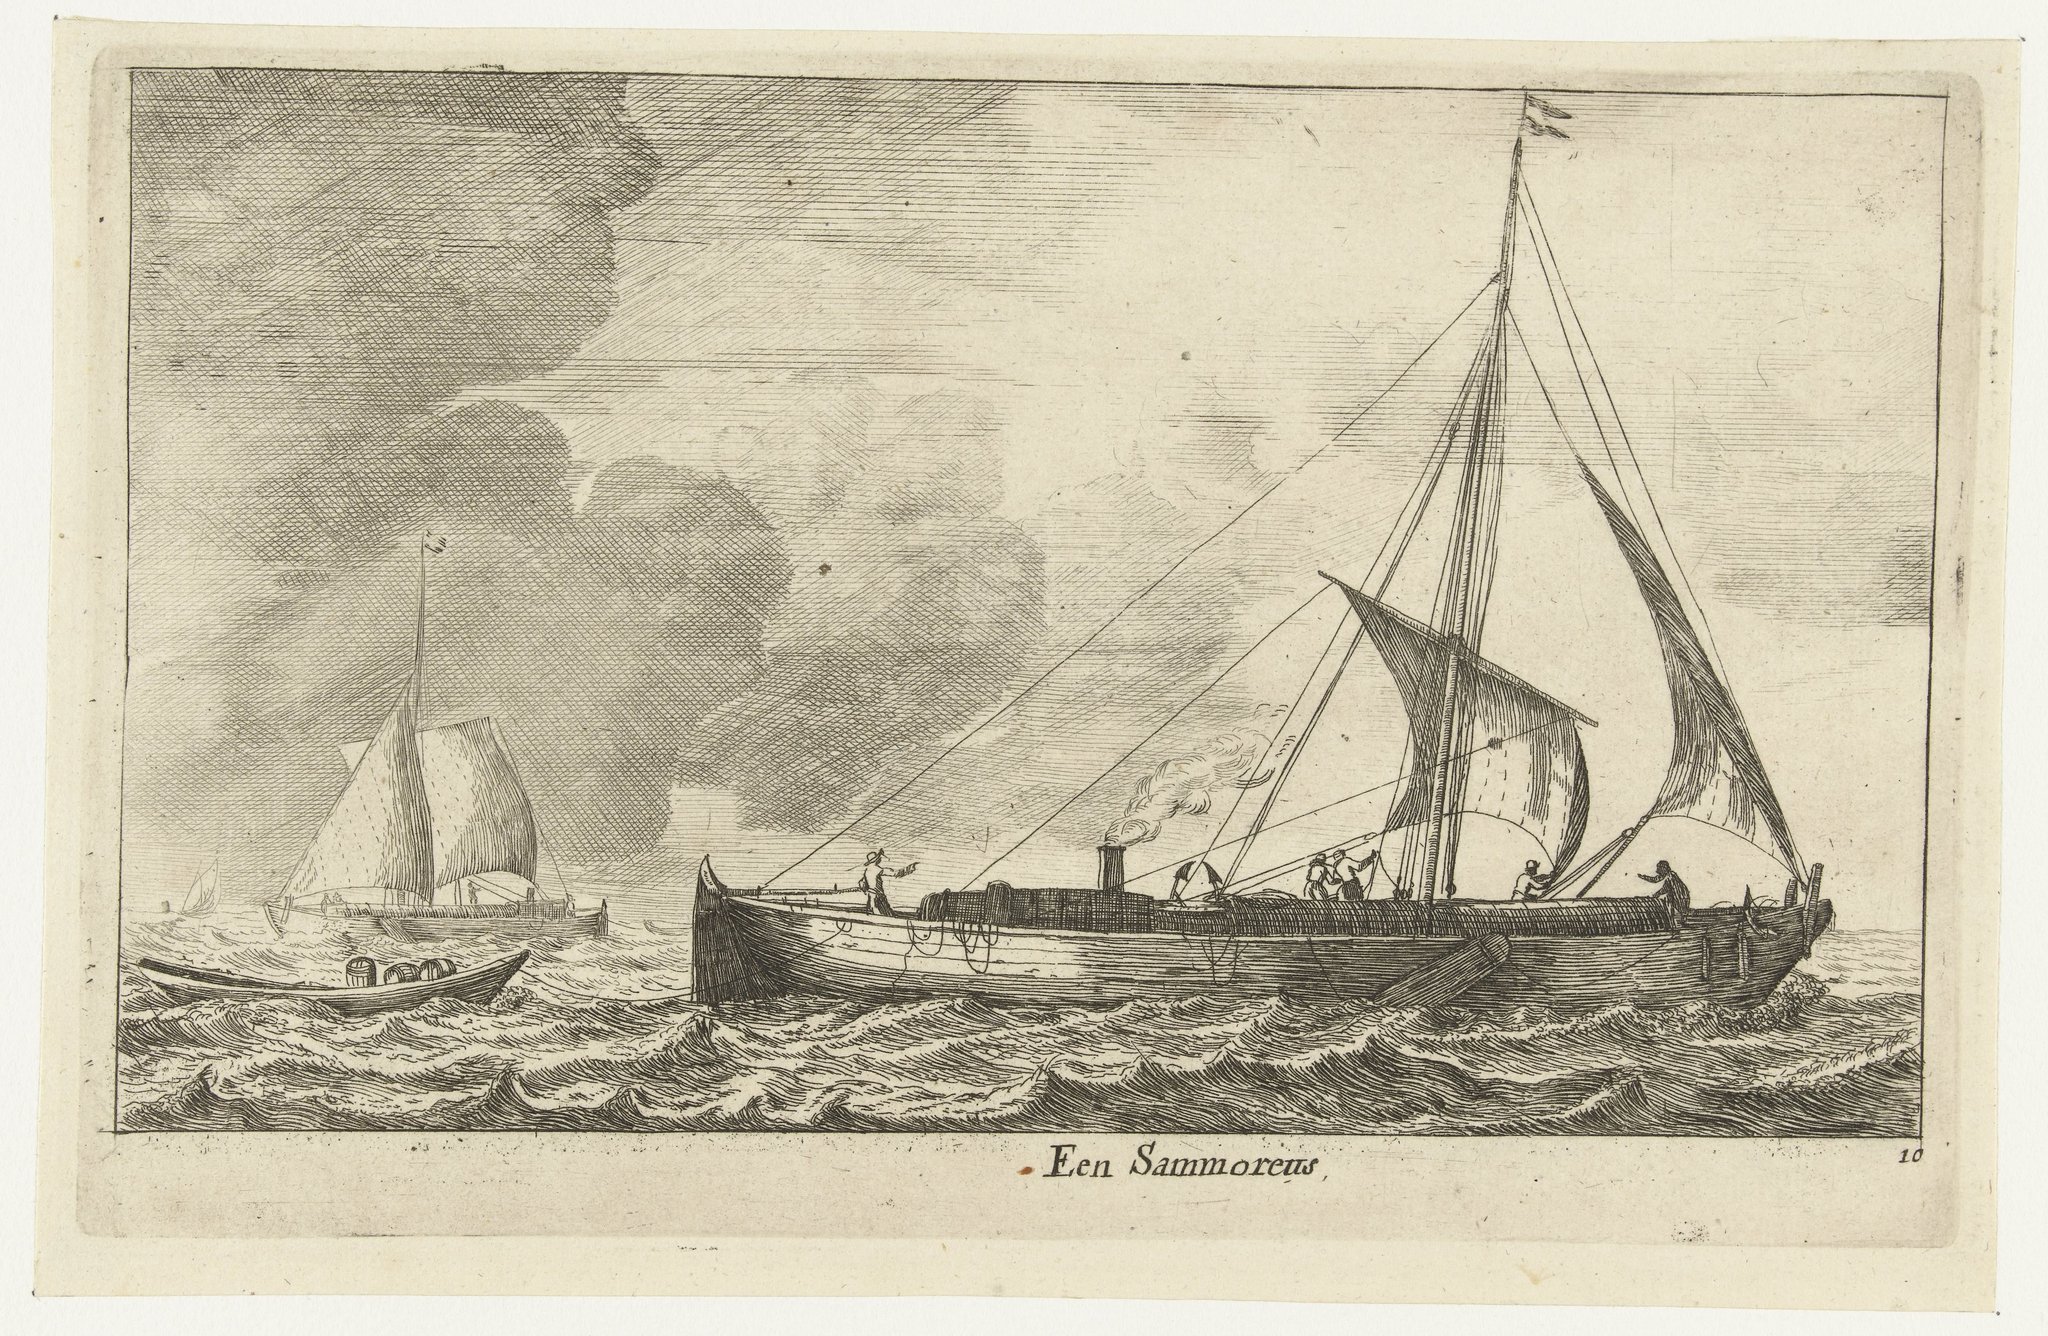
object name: print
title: Een Sammoreus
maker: Anonymous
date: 1652-1714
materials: paper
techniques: drypoint, etching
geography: netherlands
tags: sailing-ship, sailing-boat (with name)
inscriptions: collector's mark: Lugt 2228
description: Kopie in spiegelbeeld. Een Samoreus, een in de streek van Keulen gebouwde rijnaak.